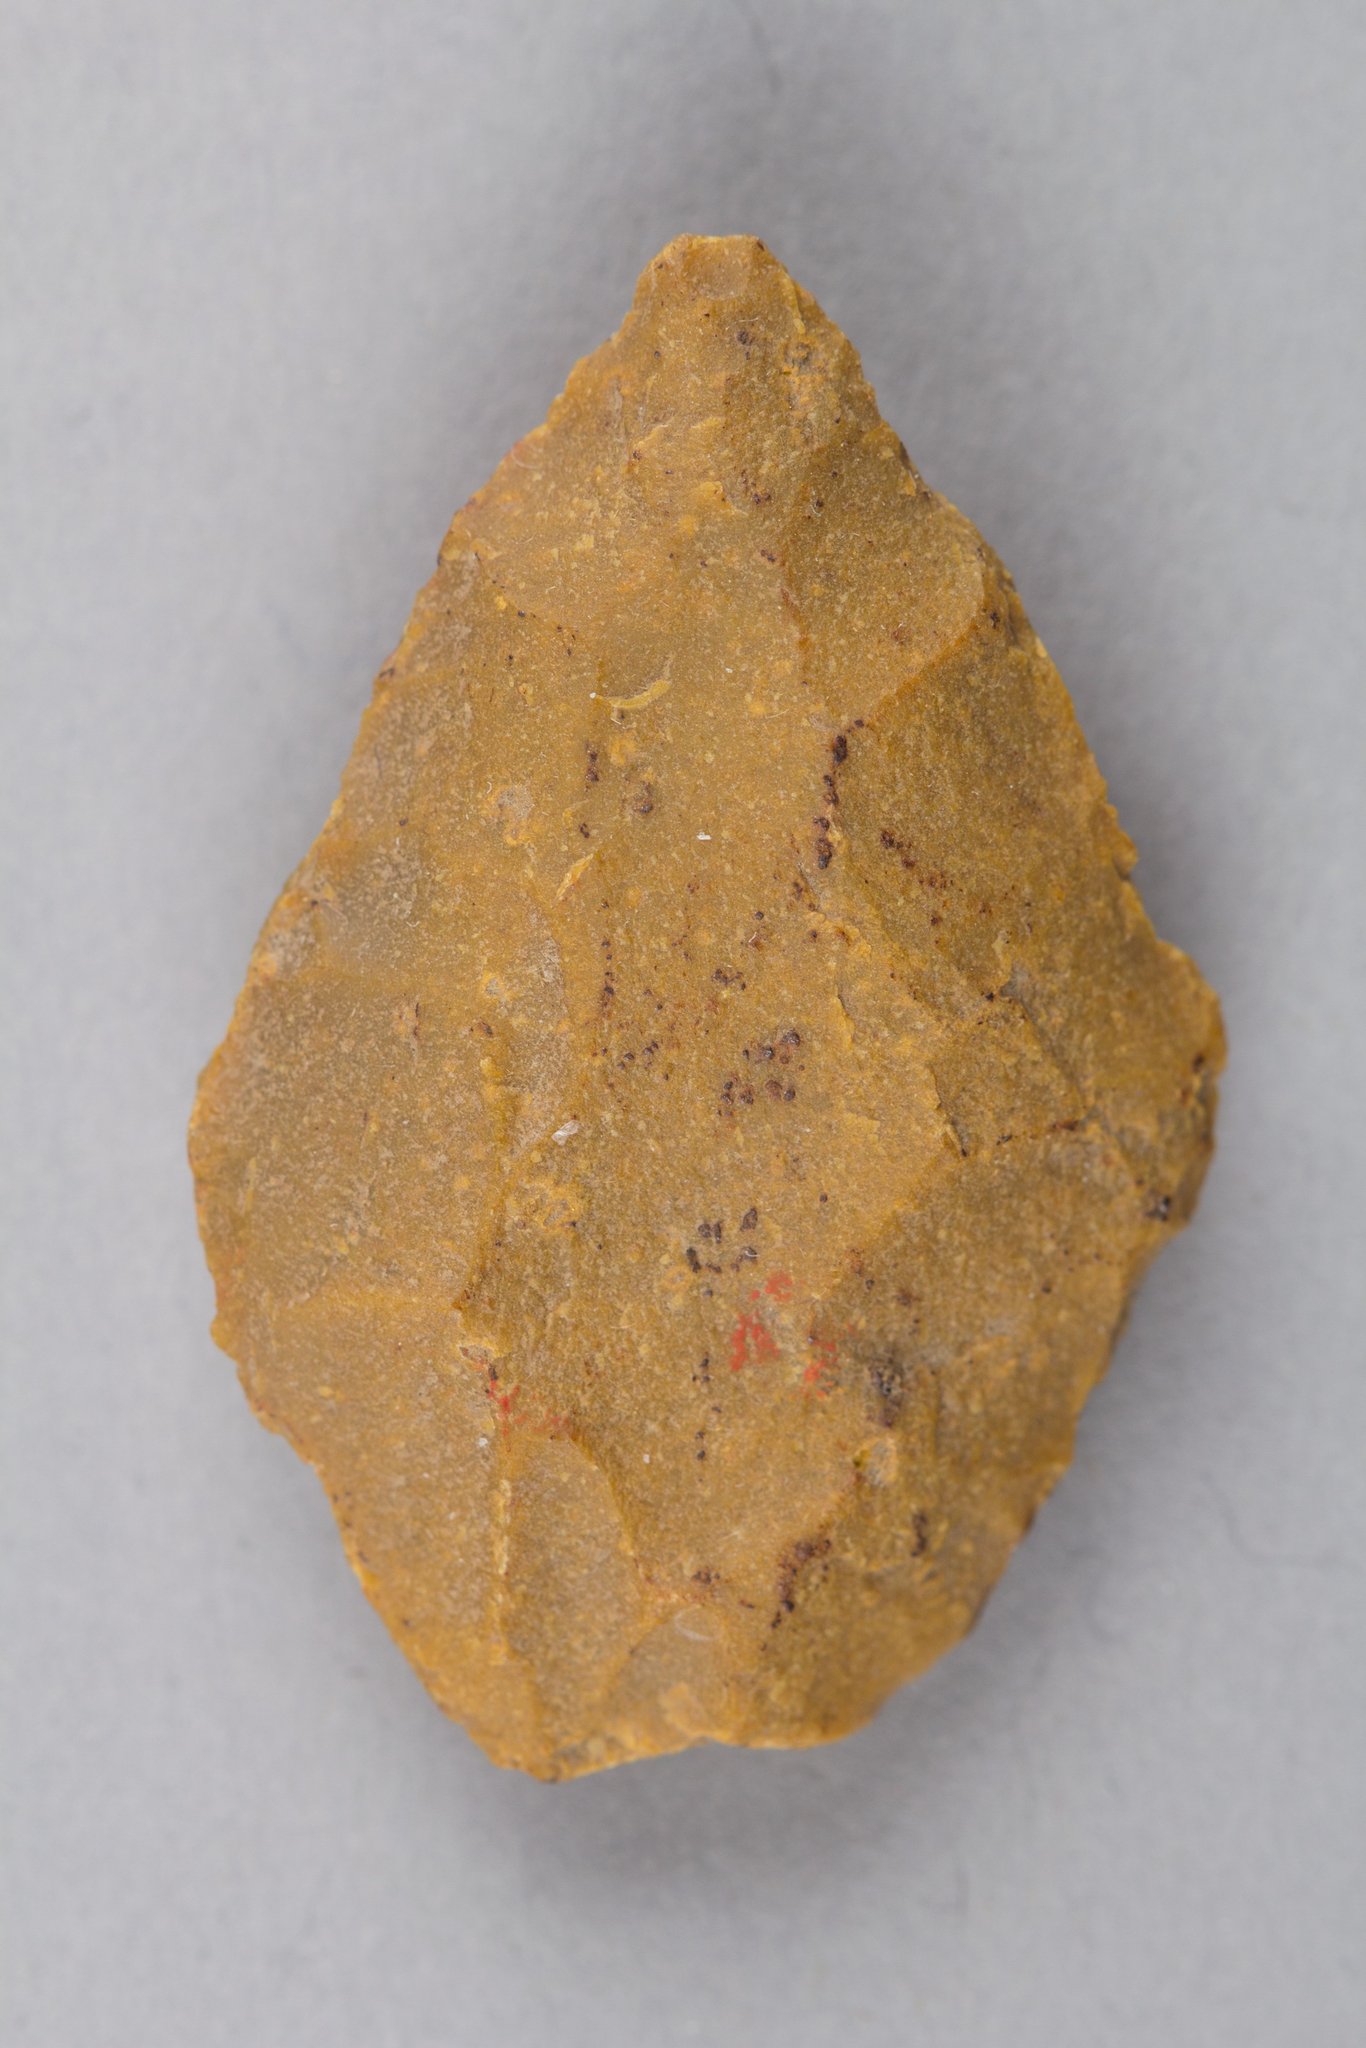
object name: arrowhead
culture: japanese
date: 1500-1000 BCE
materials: stone